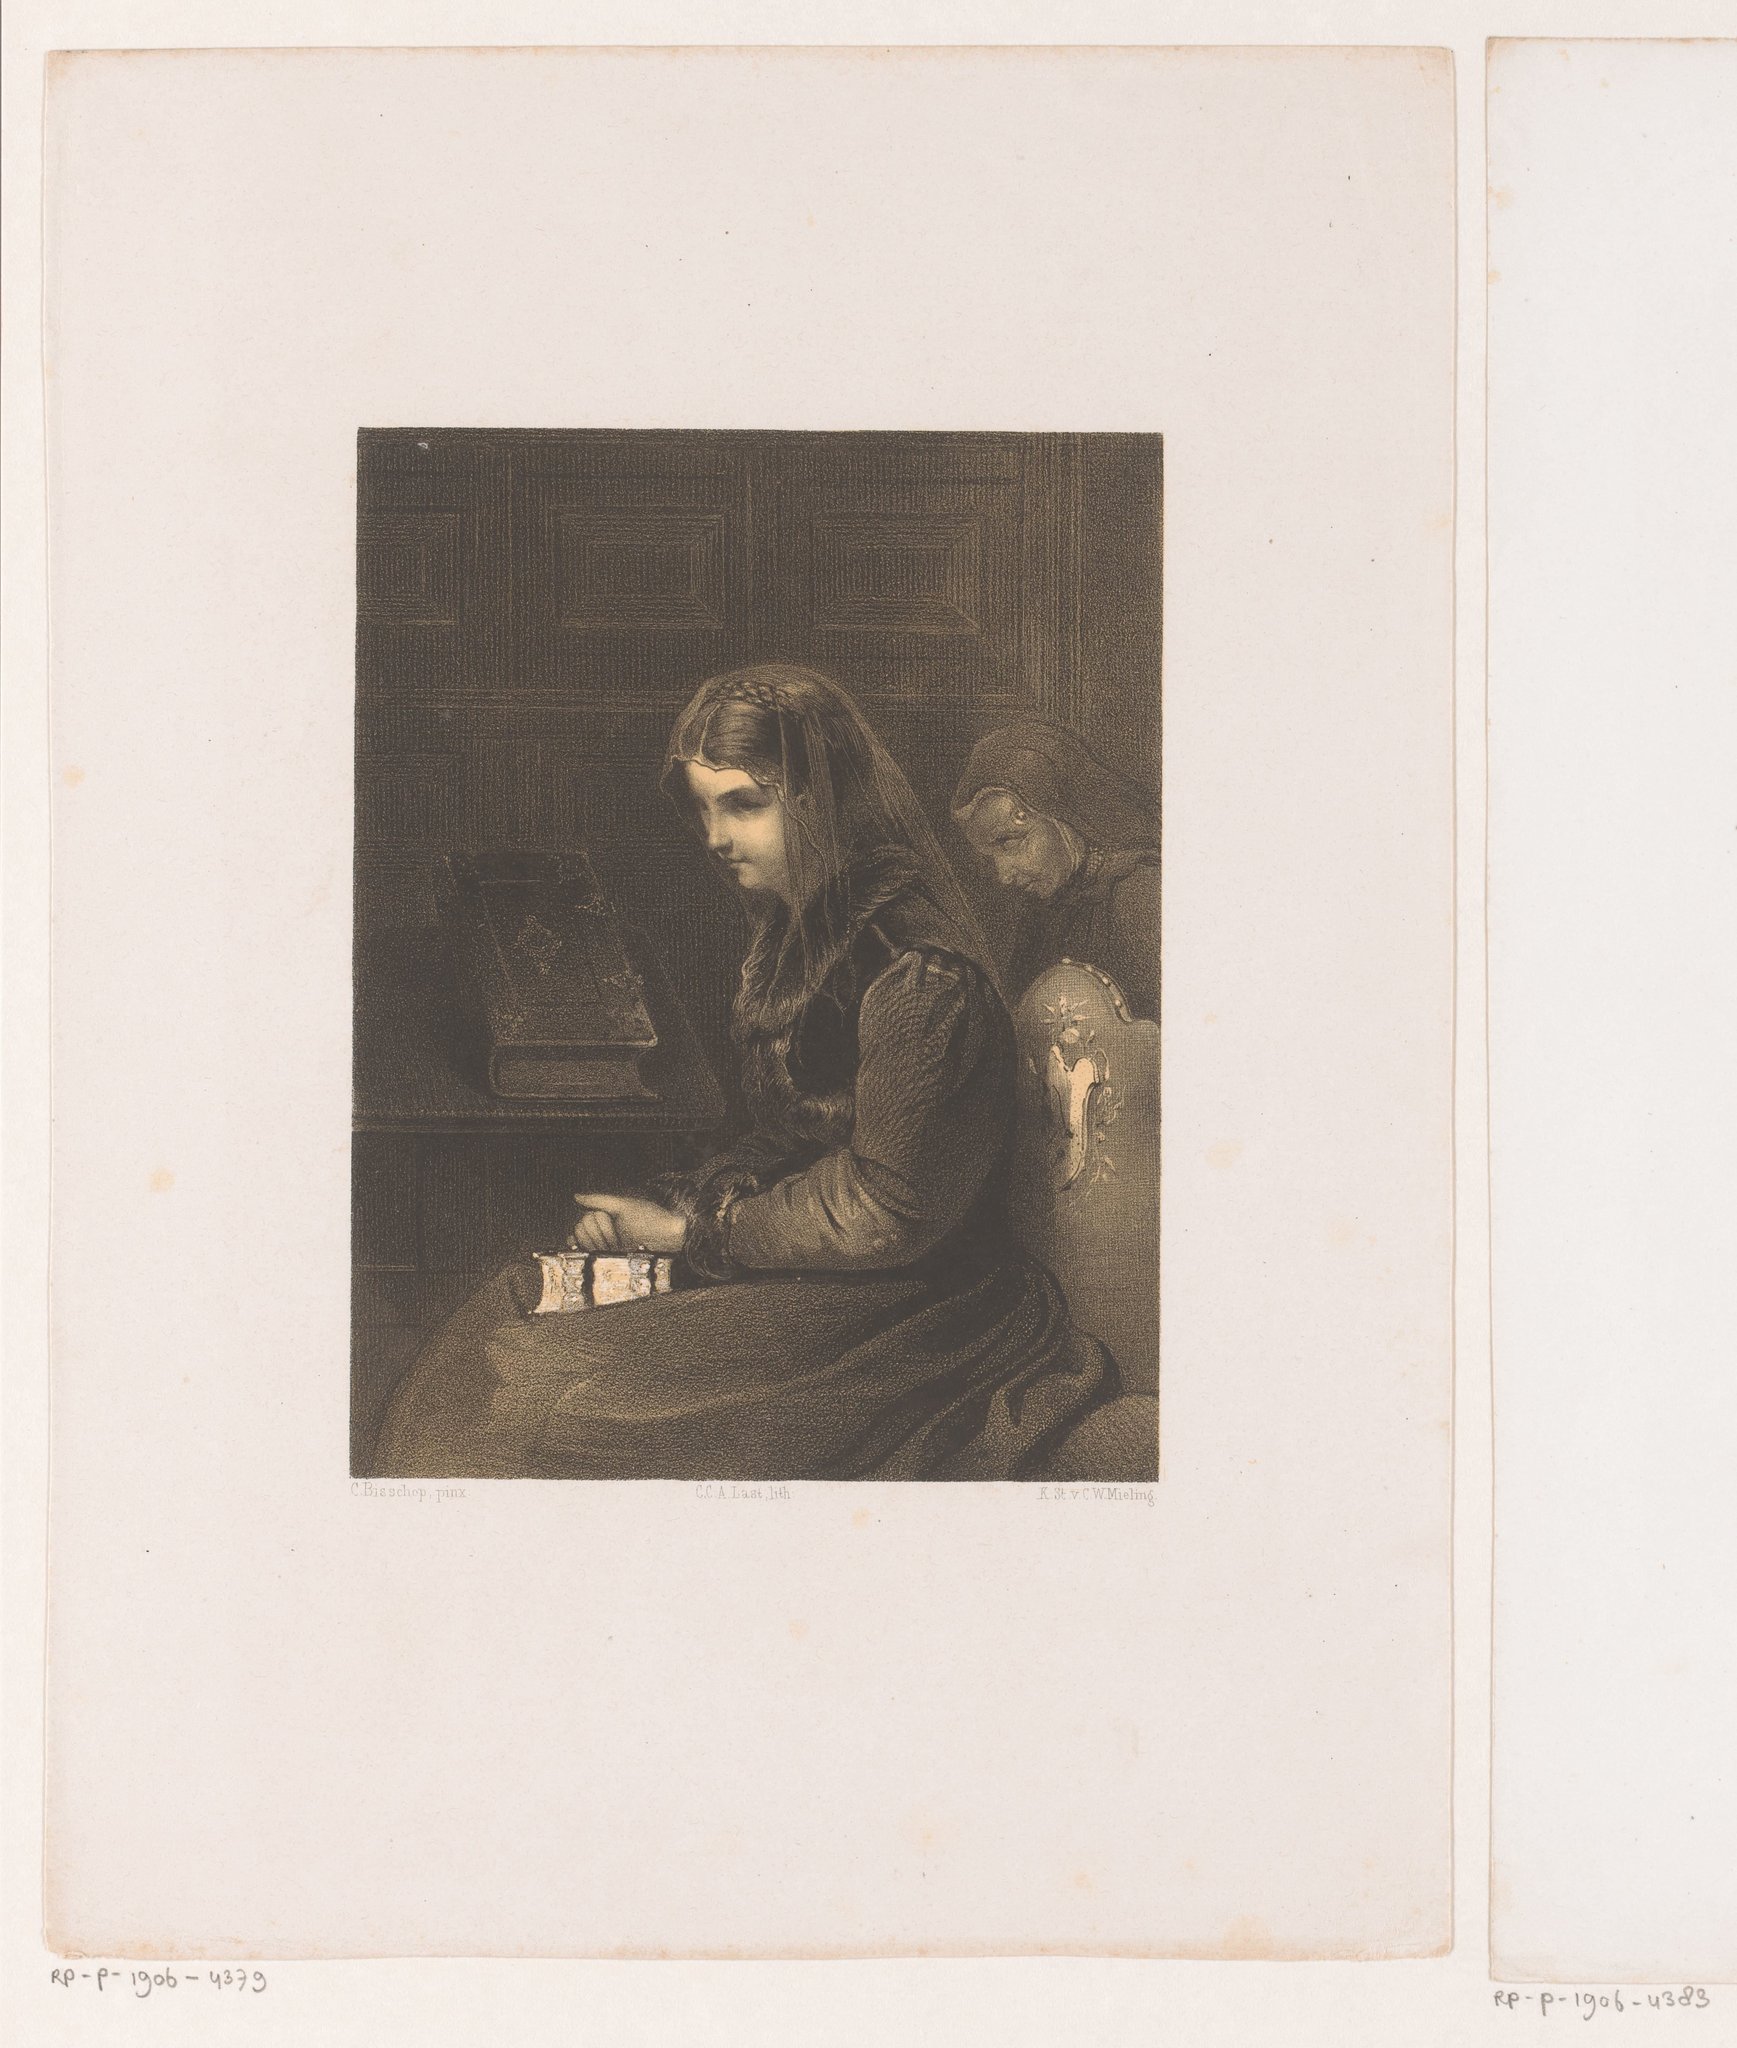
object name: print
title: Gesluierde vrouw met Bijbel op schoot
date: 1847-1863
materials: paper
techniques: tone lithography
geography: the hague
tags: veil, one person praying, the bible as a book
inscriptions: collector's mark: Lugt 2228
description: Achter de jonge vrouw zit een oudere vrouw in gebed.